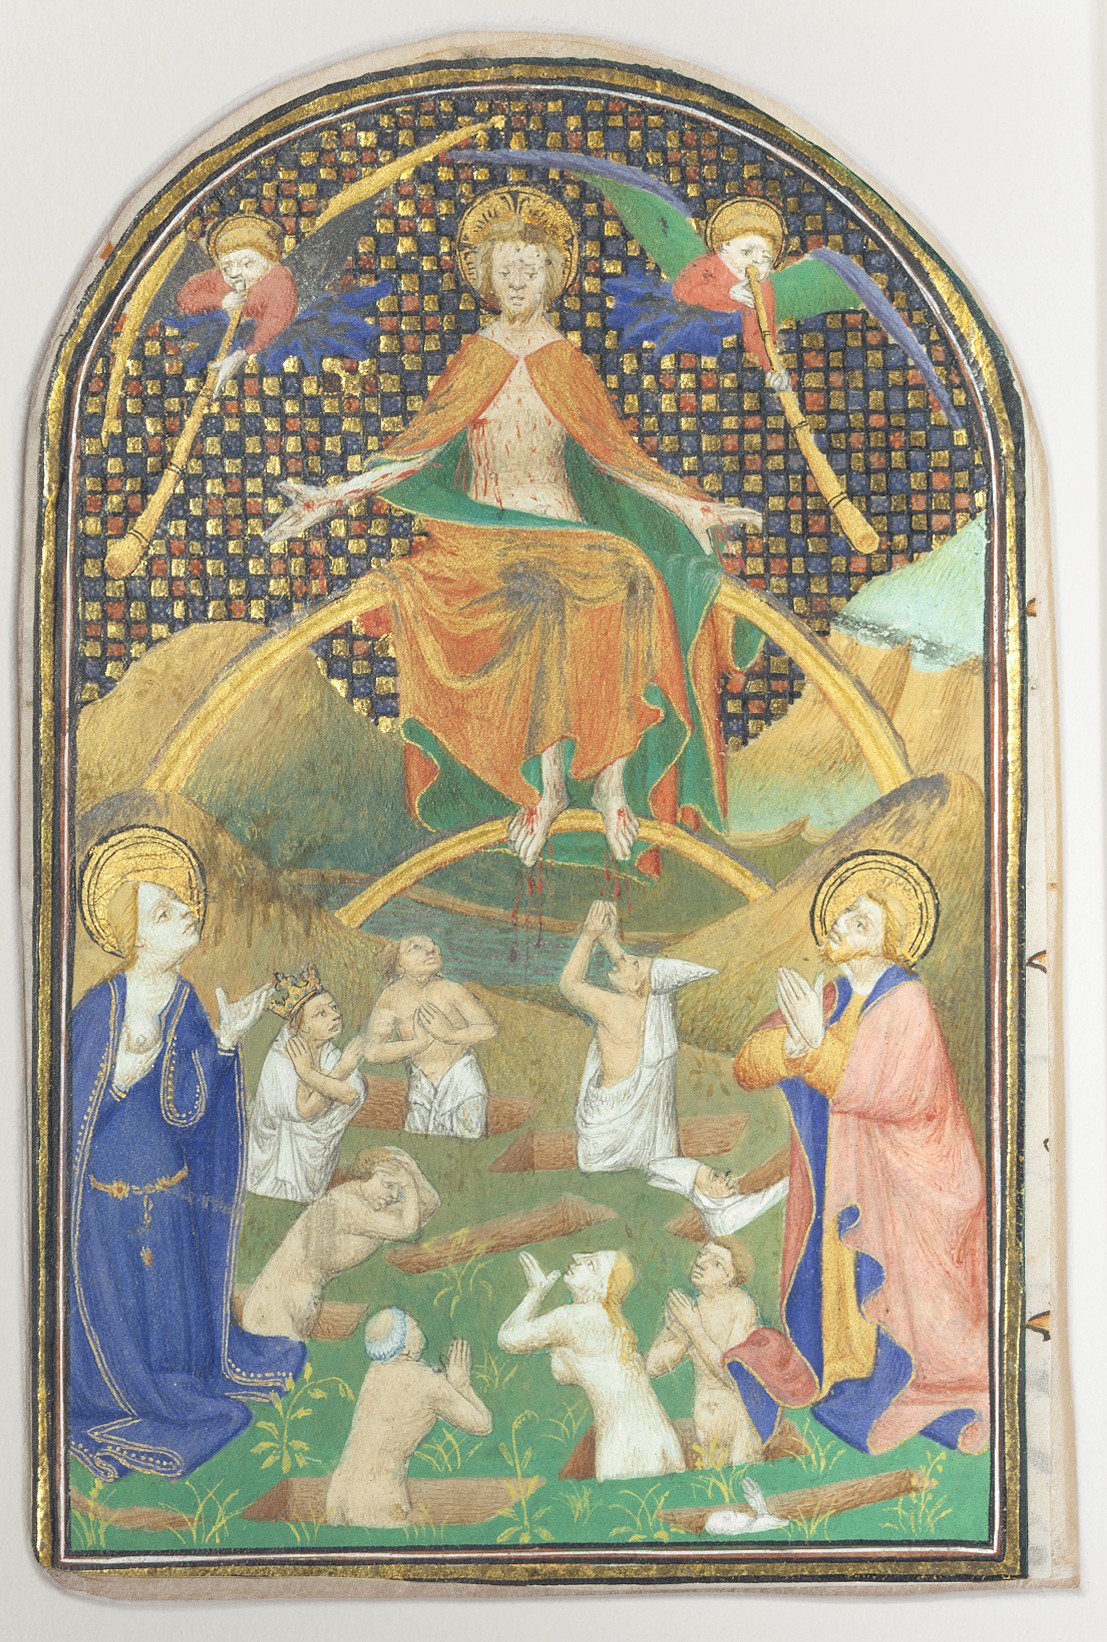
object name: book of hour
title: Manuscript Leaf with the Last Judgment, from a Book of Hours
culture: french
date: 1400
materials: gold, parchment, paint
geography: france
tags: angels,virgin mary,jesus,last judgement